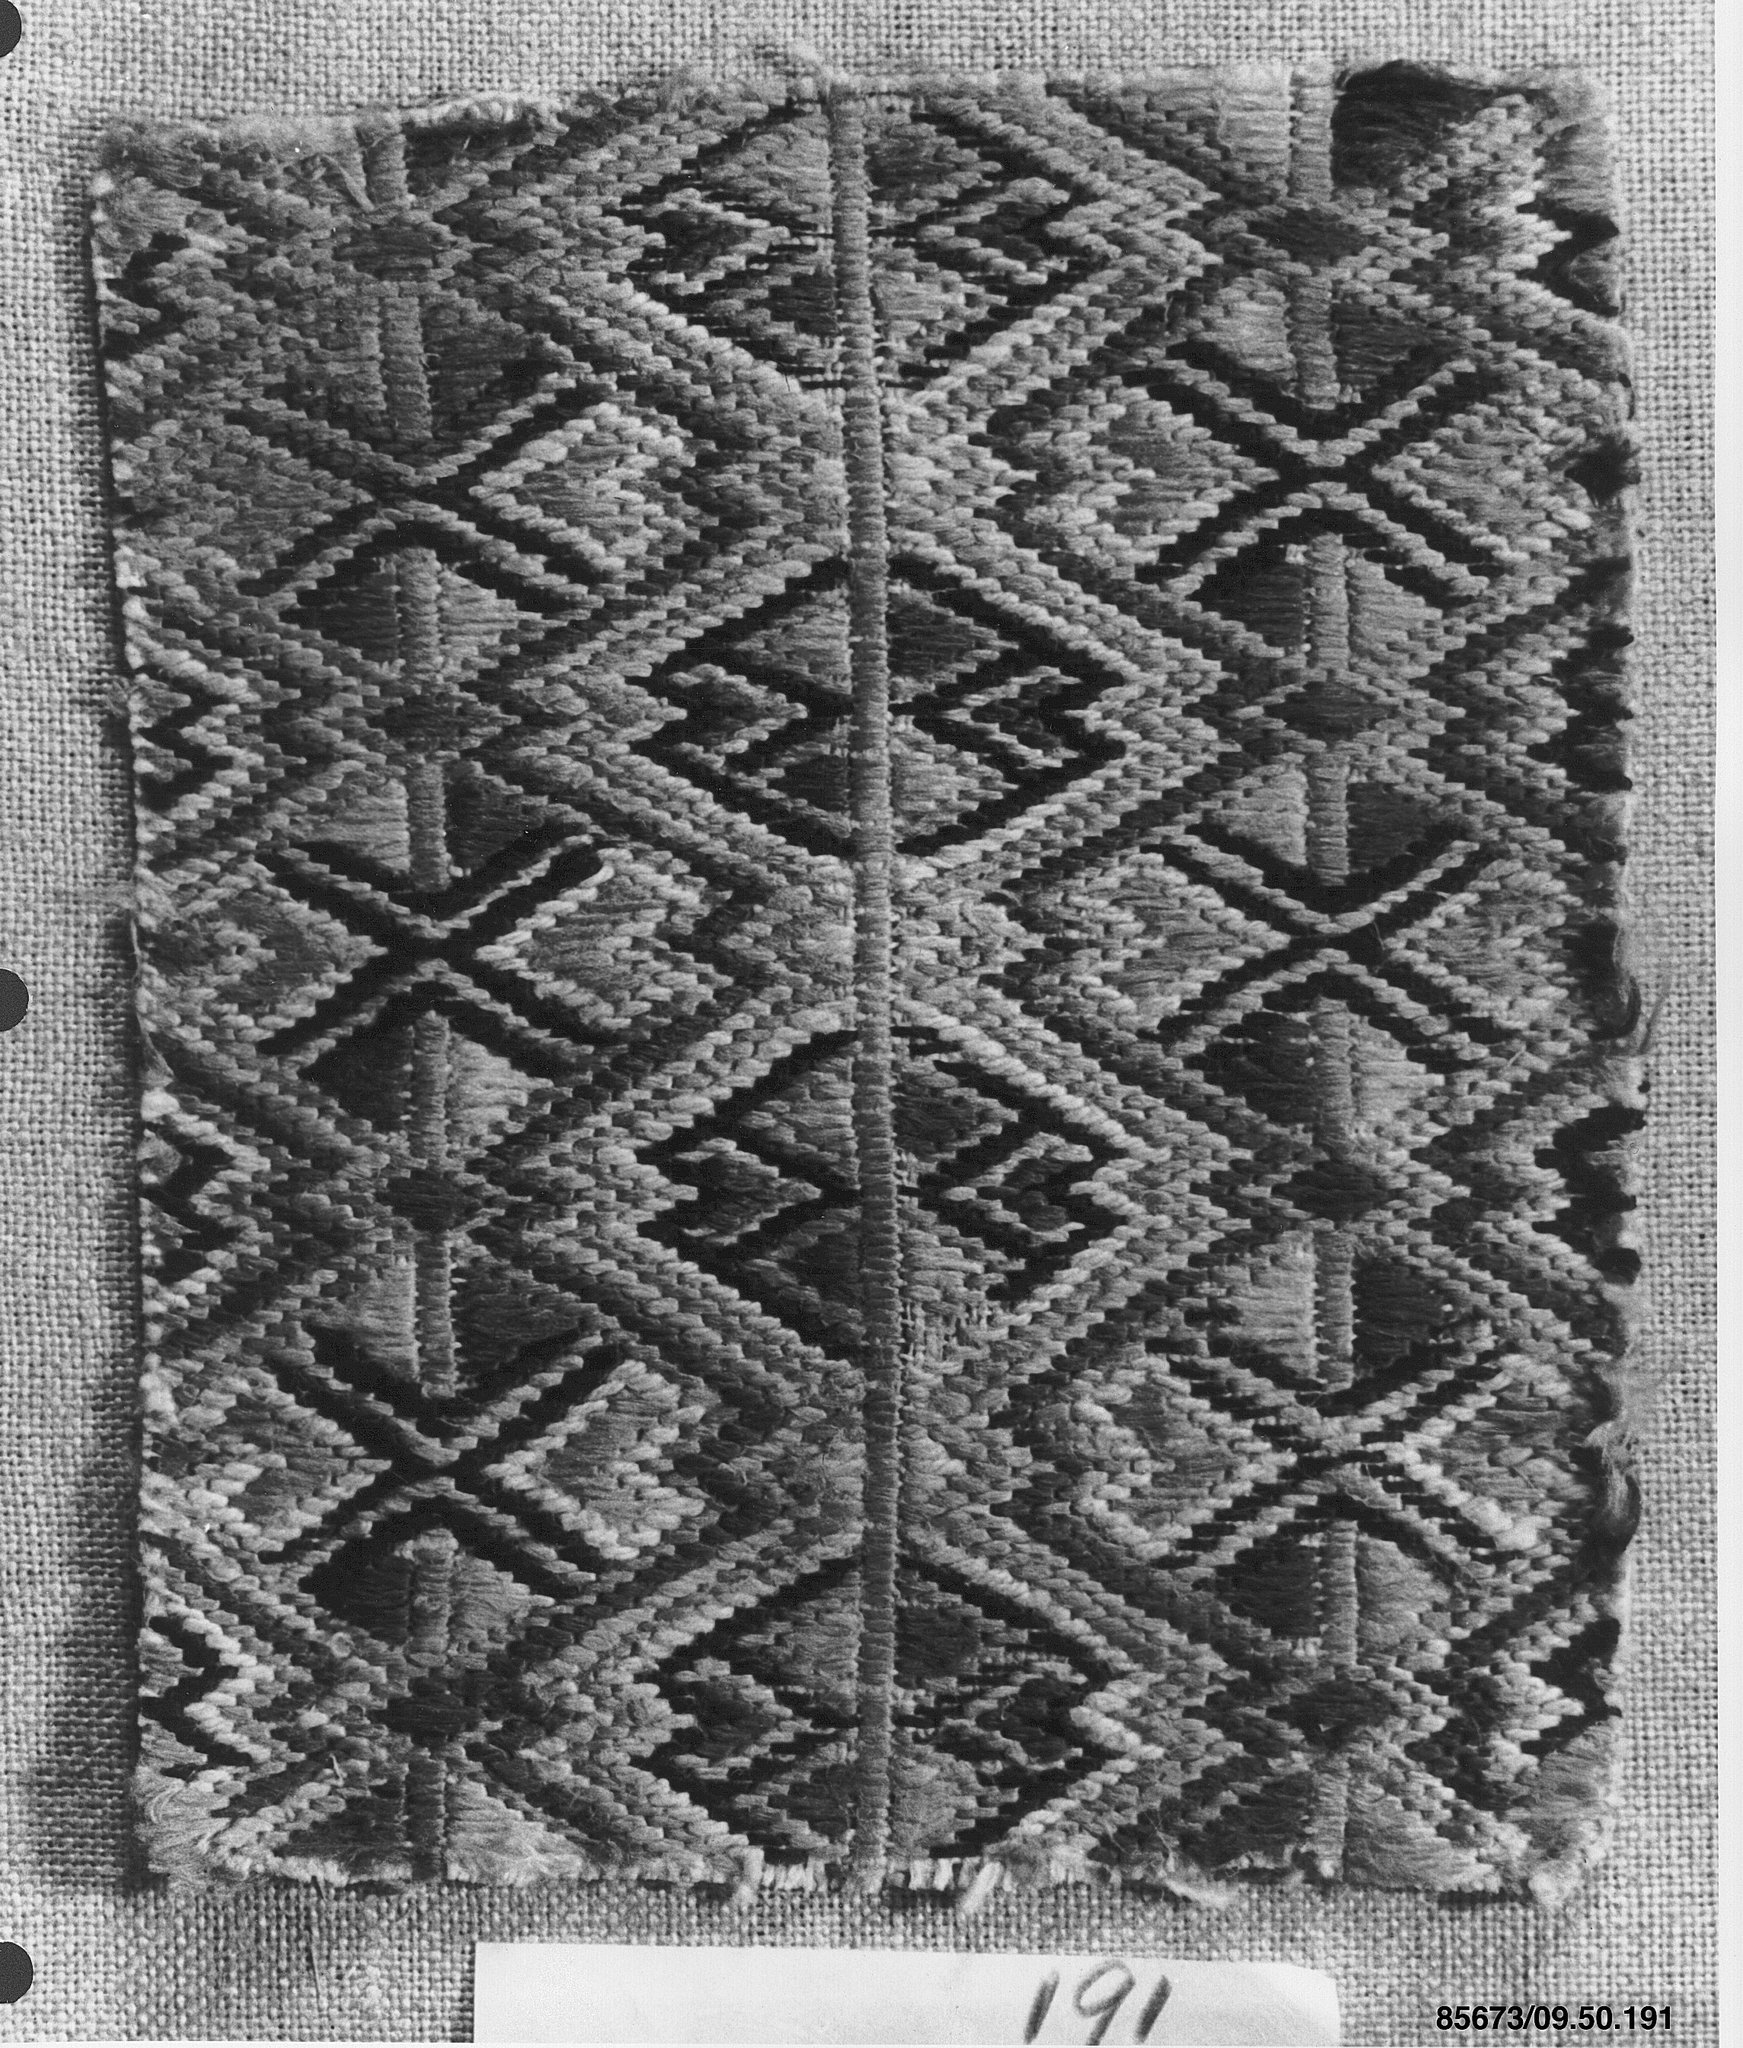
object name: costume fragment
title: Peasant costume fragment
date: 1701-1900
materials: linen, wool